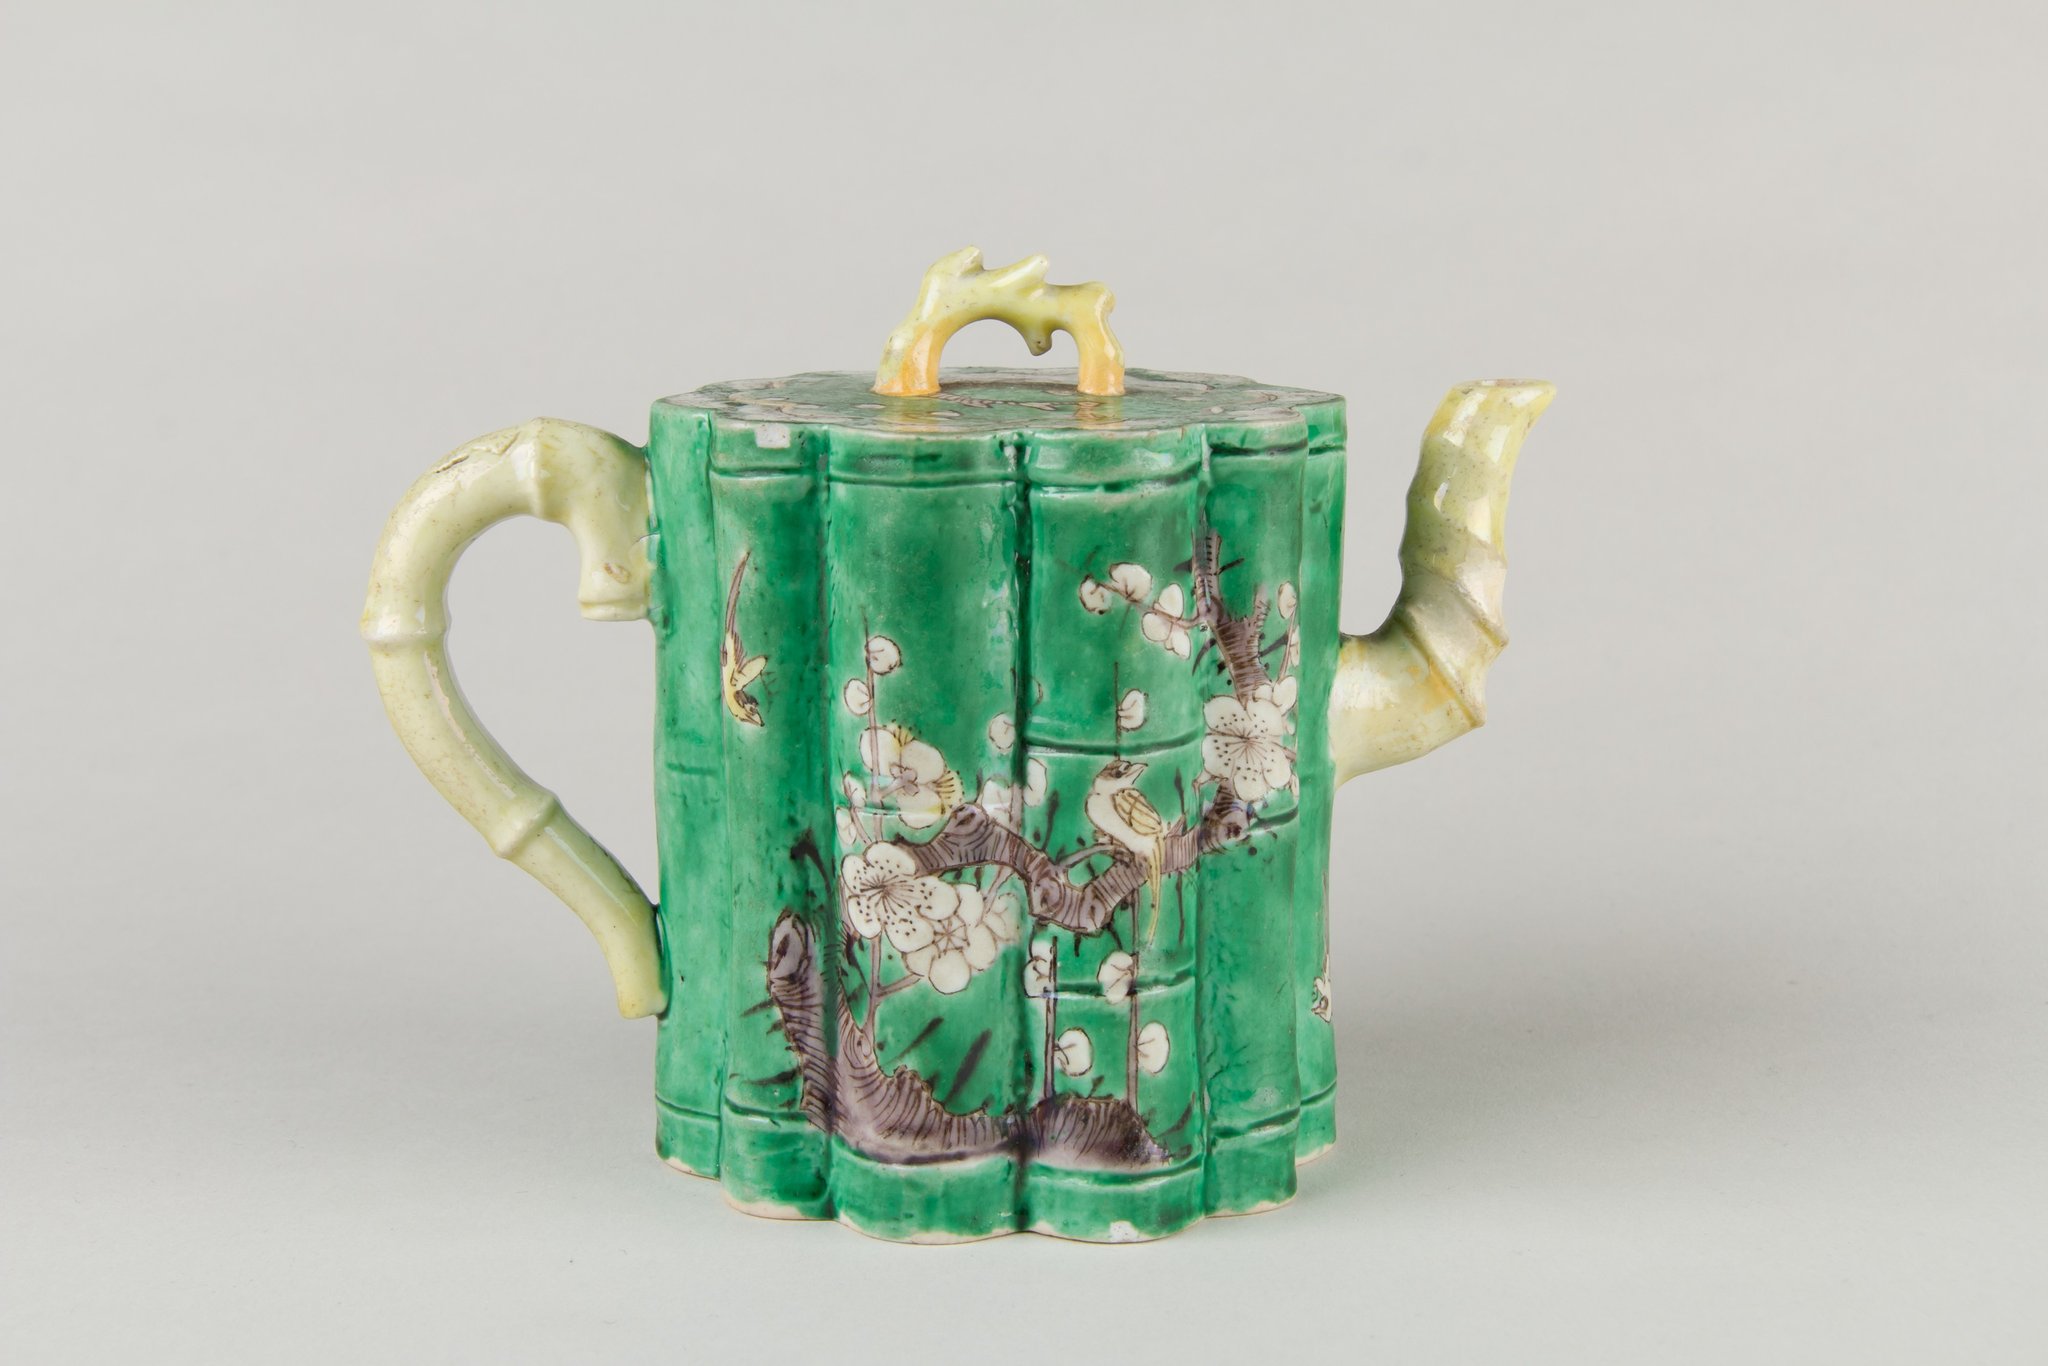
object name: teapot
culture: chinese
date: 1644-1911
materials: porcelain